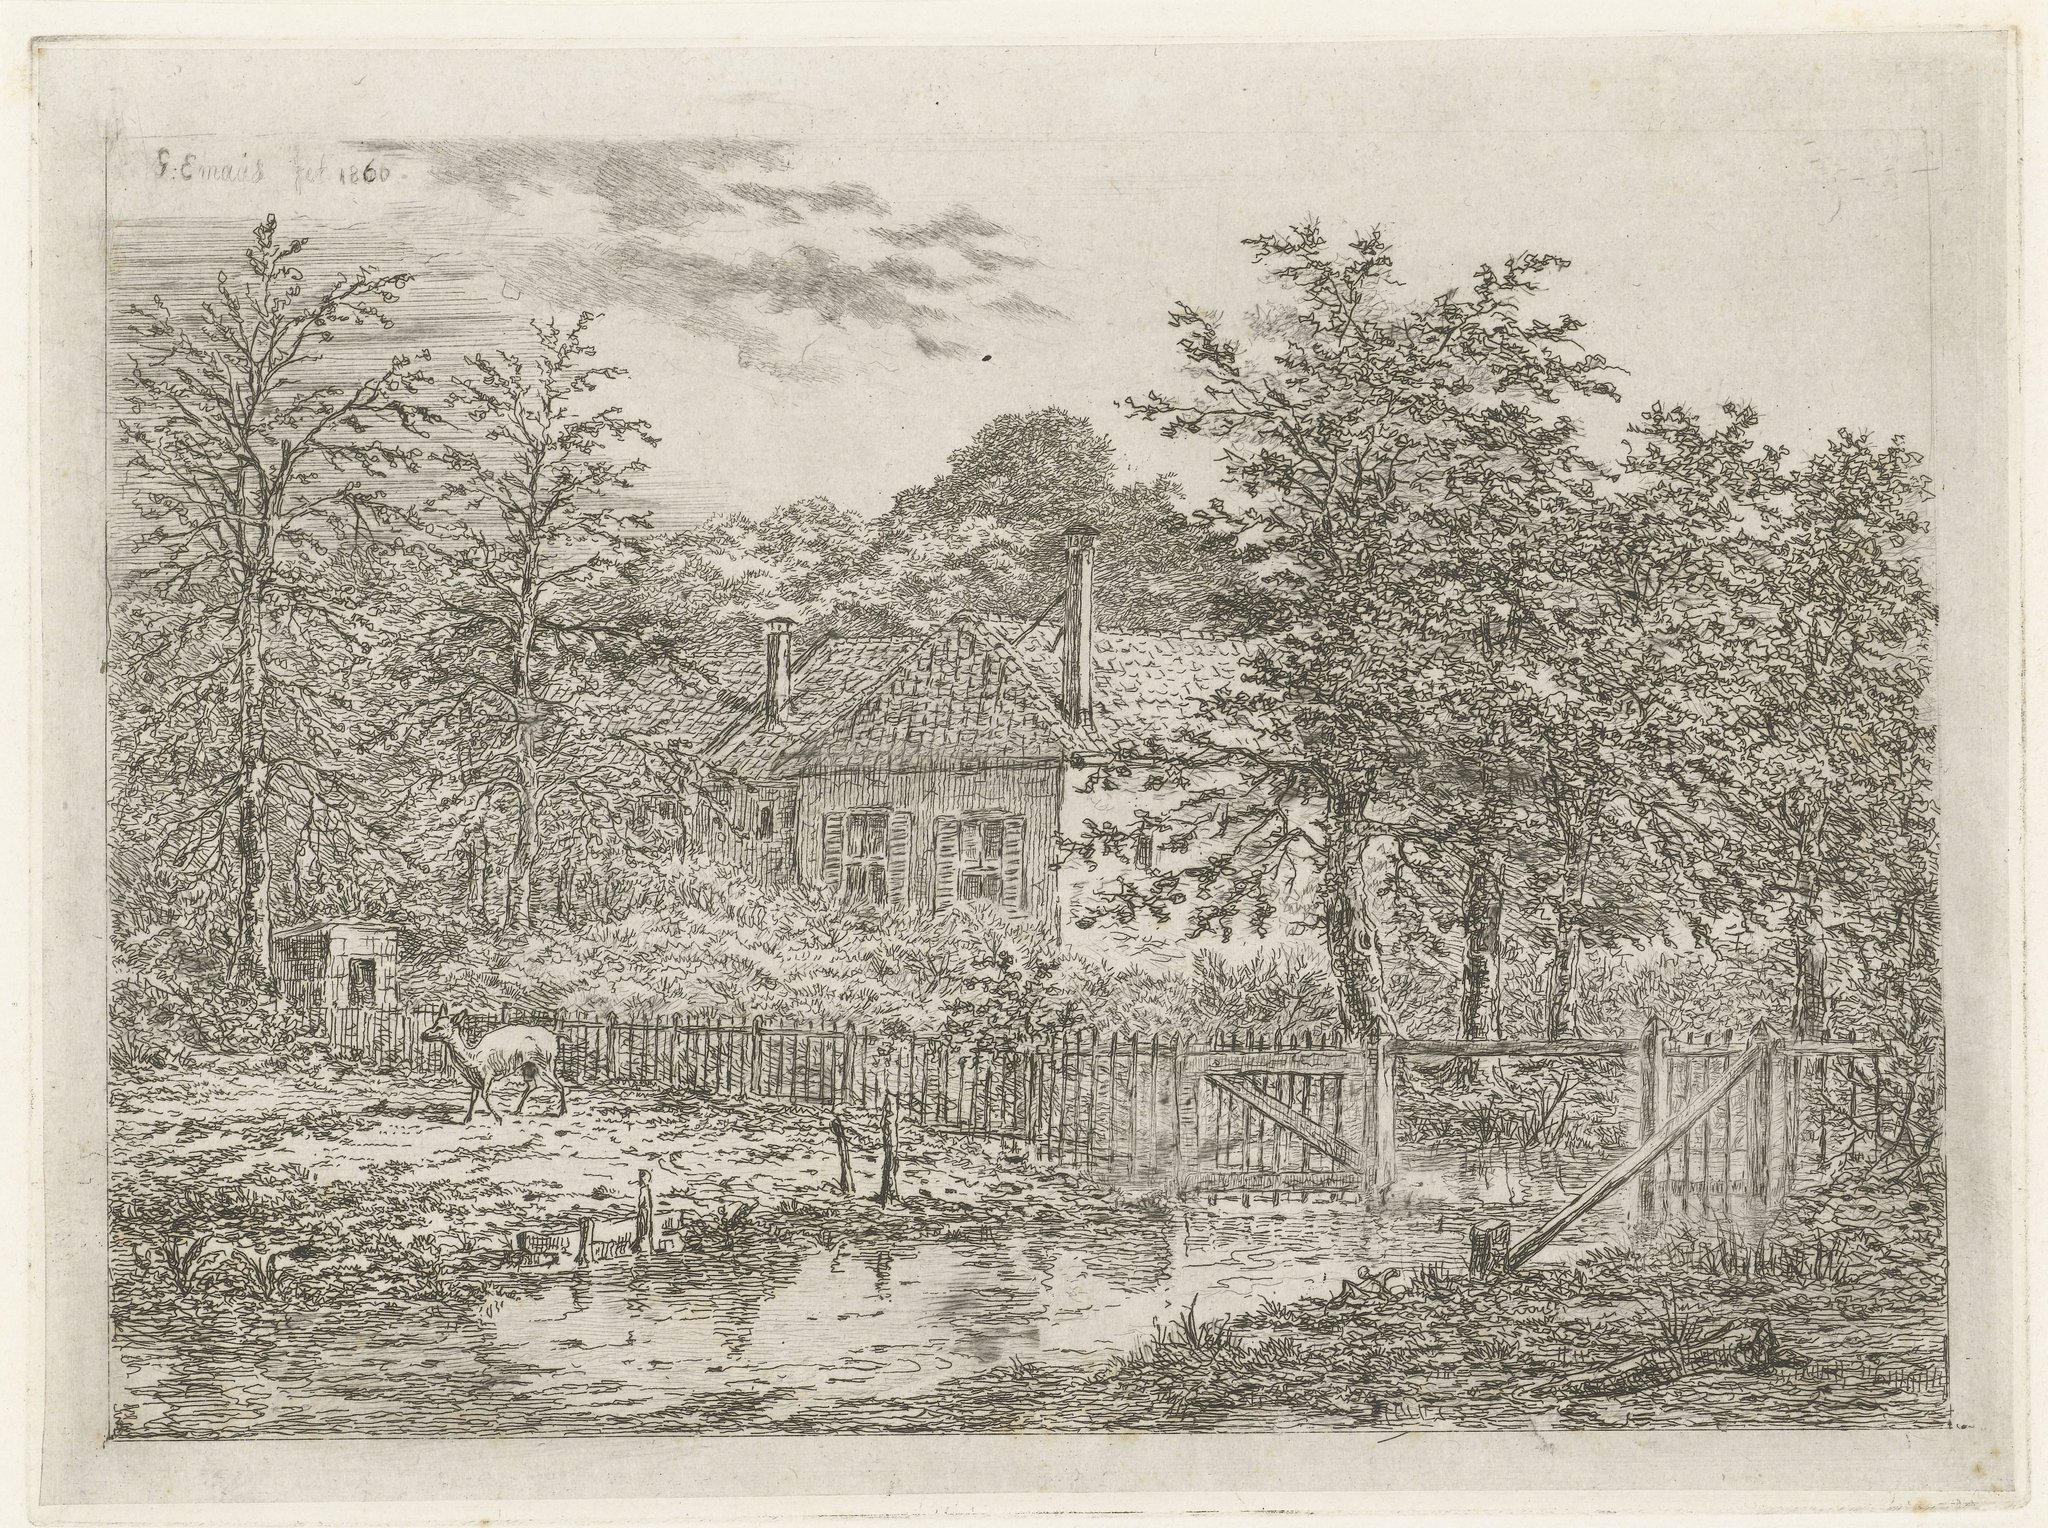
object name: print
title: Hertekamp te 's Gravenhage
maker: gerardus emaus de micault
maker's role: draughtsman, print maker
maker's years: 1798-1863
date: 1860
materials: paper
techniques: etching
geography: netherlands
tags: hoofed animals: deer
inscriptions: collector's mark: Lugt 1485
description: Gezicht op een tussen bomen en struiken gelegen huis, met bij het hek een hert.